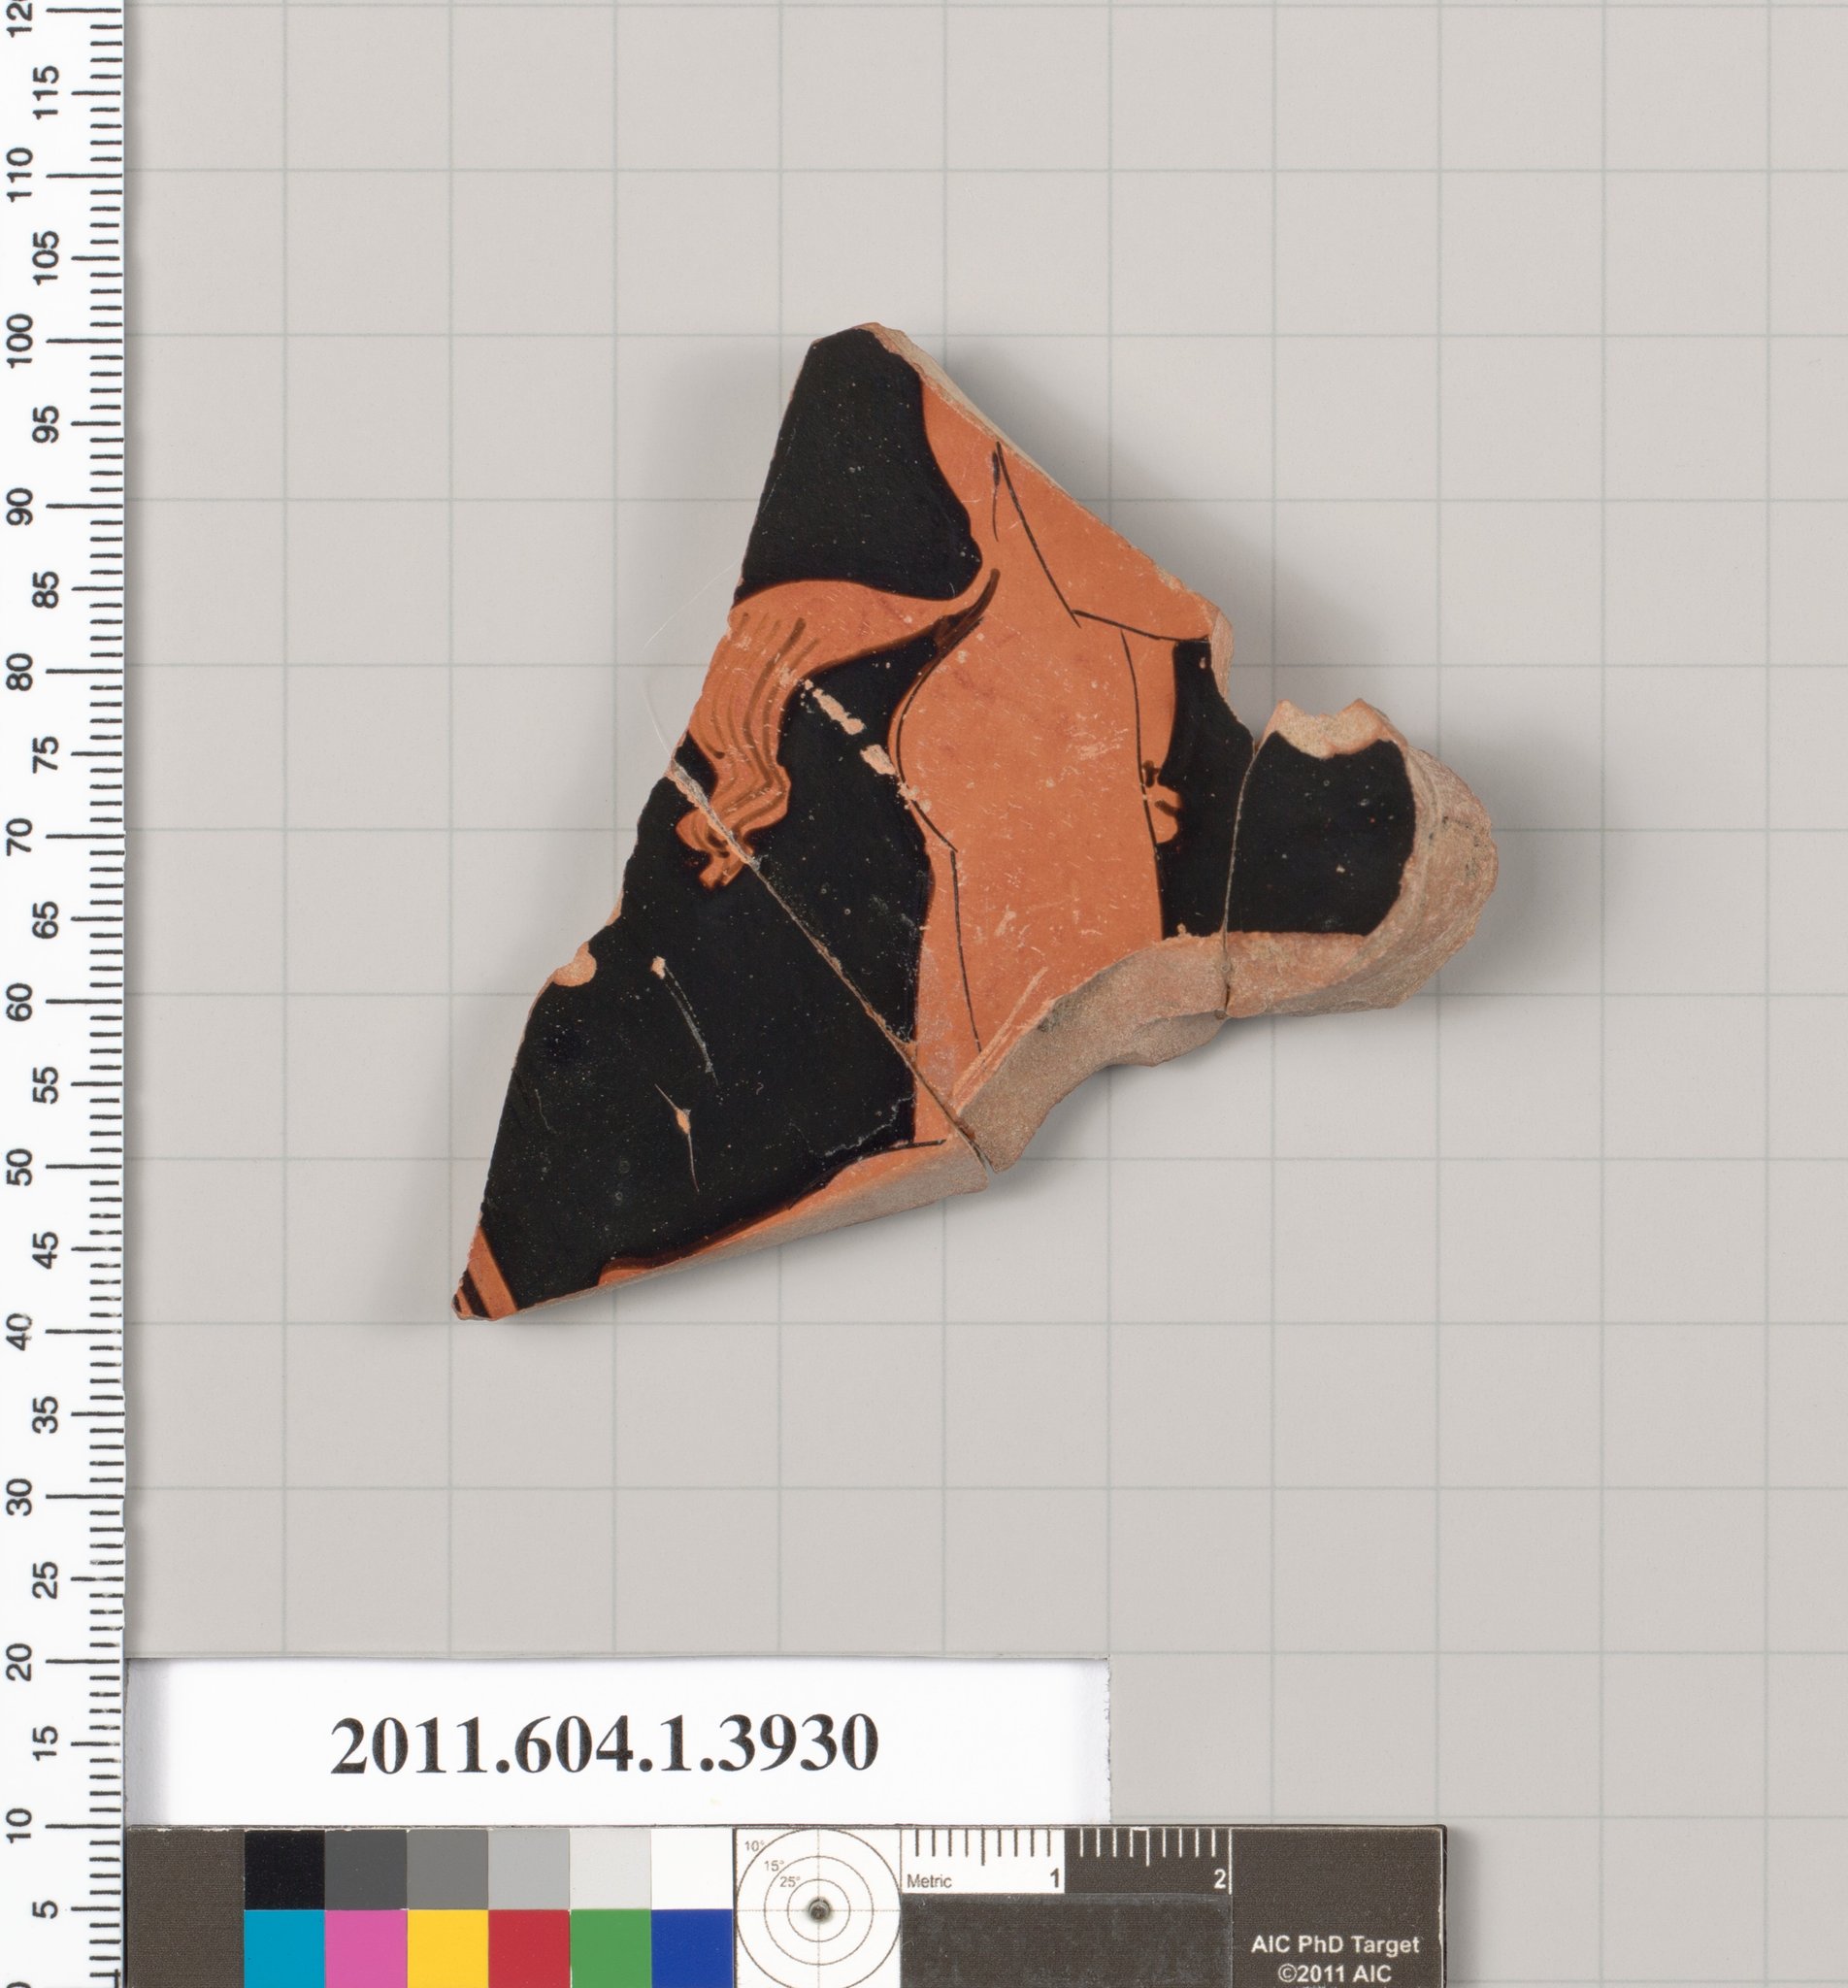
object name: kylix fragment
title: Terracotta fragment of a kylix (drinking cup)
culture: greek, attic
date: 475-451 BCE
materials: terracotta